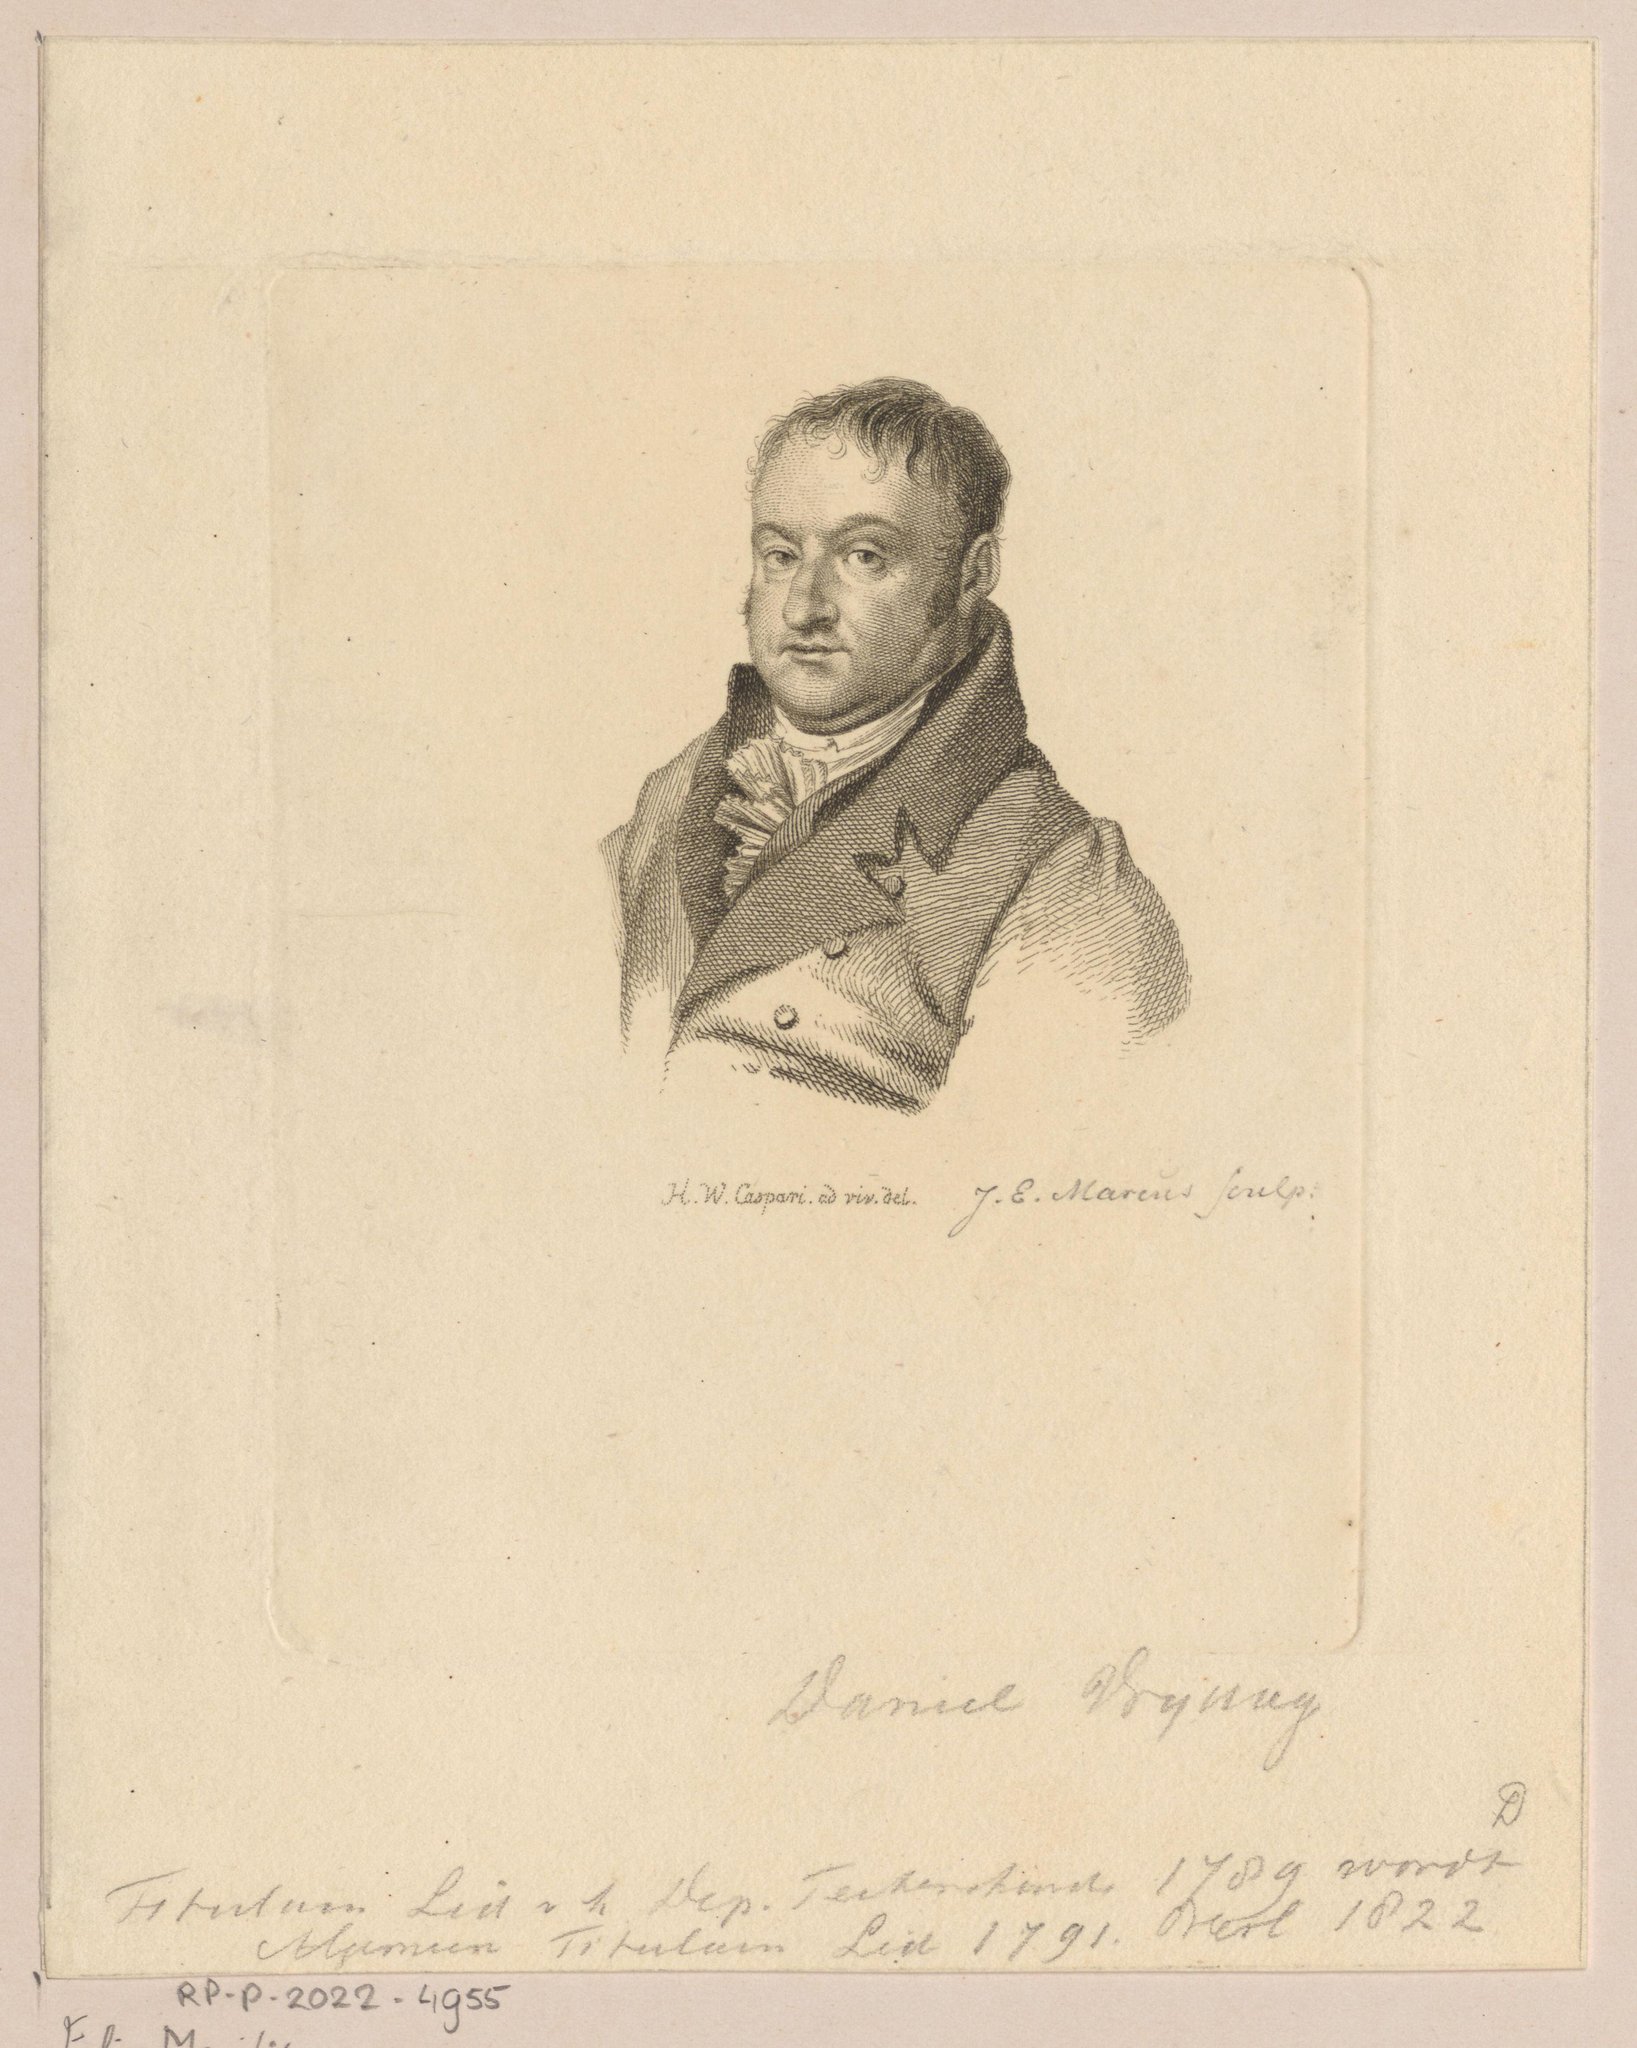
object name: print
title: Portret van Daniël Vrijdag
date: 1812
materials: paper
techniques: etching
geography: netherlands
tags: the hague, print maker, draughtsman, daniël vrijdag, historical persons, portrait, self-portrait of graphic artist, portrait, self-portrait of draughtsman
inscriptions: collector's mark: Lugt 924